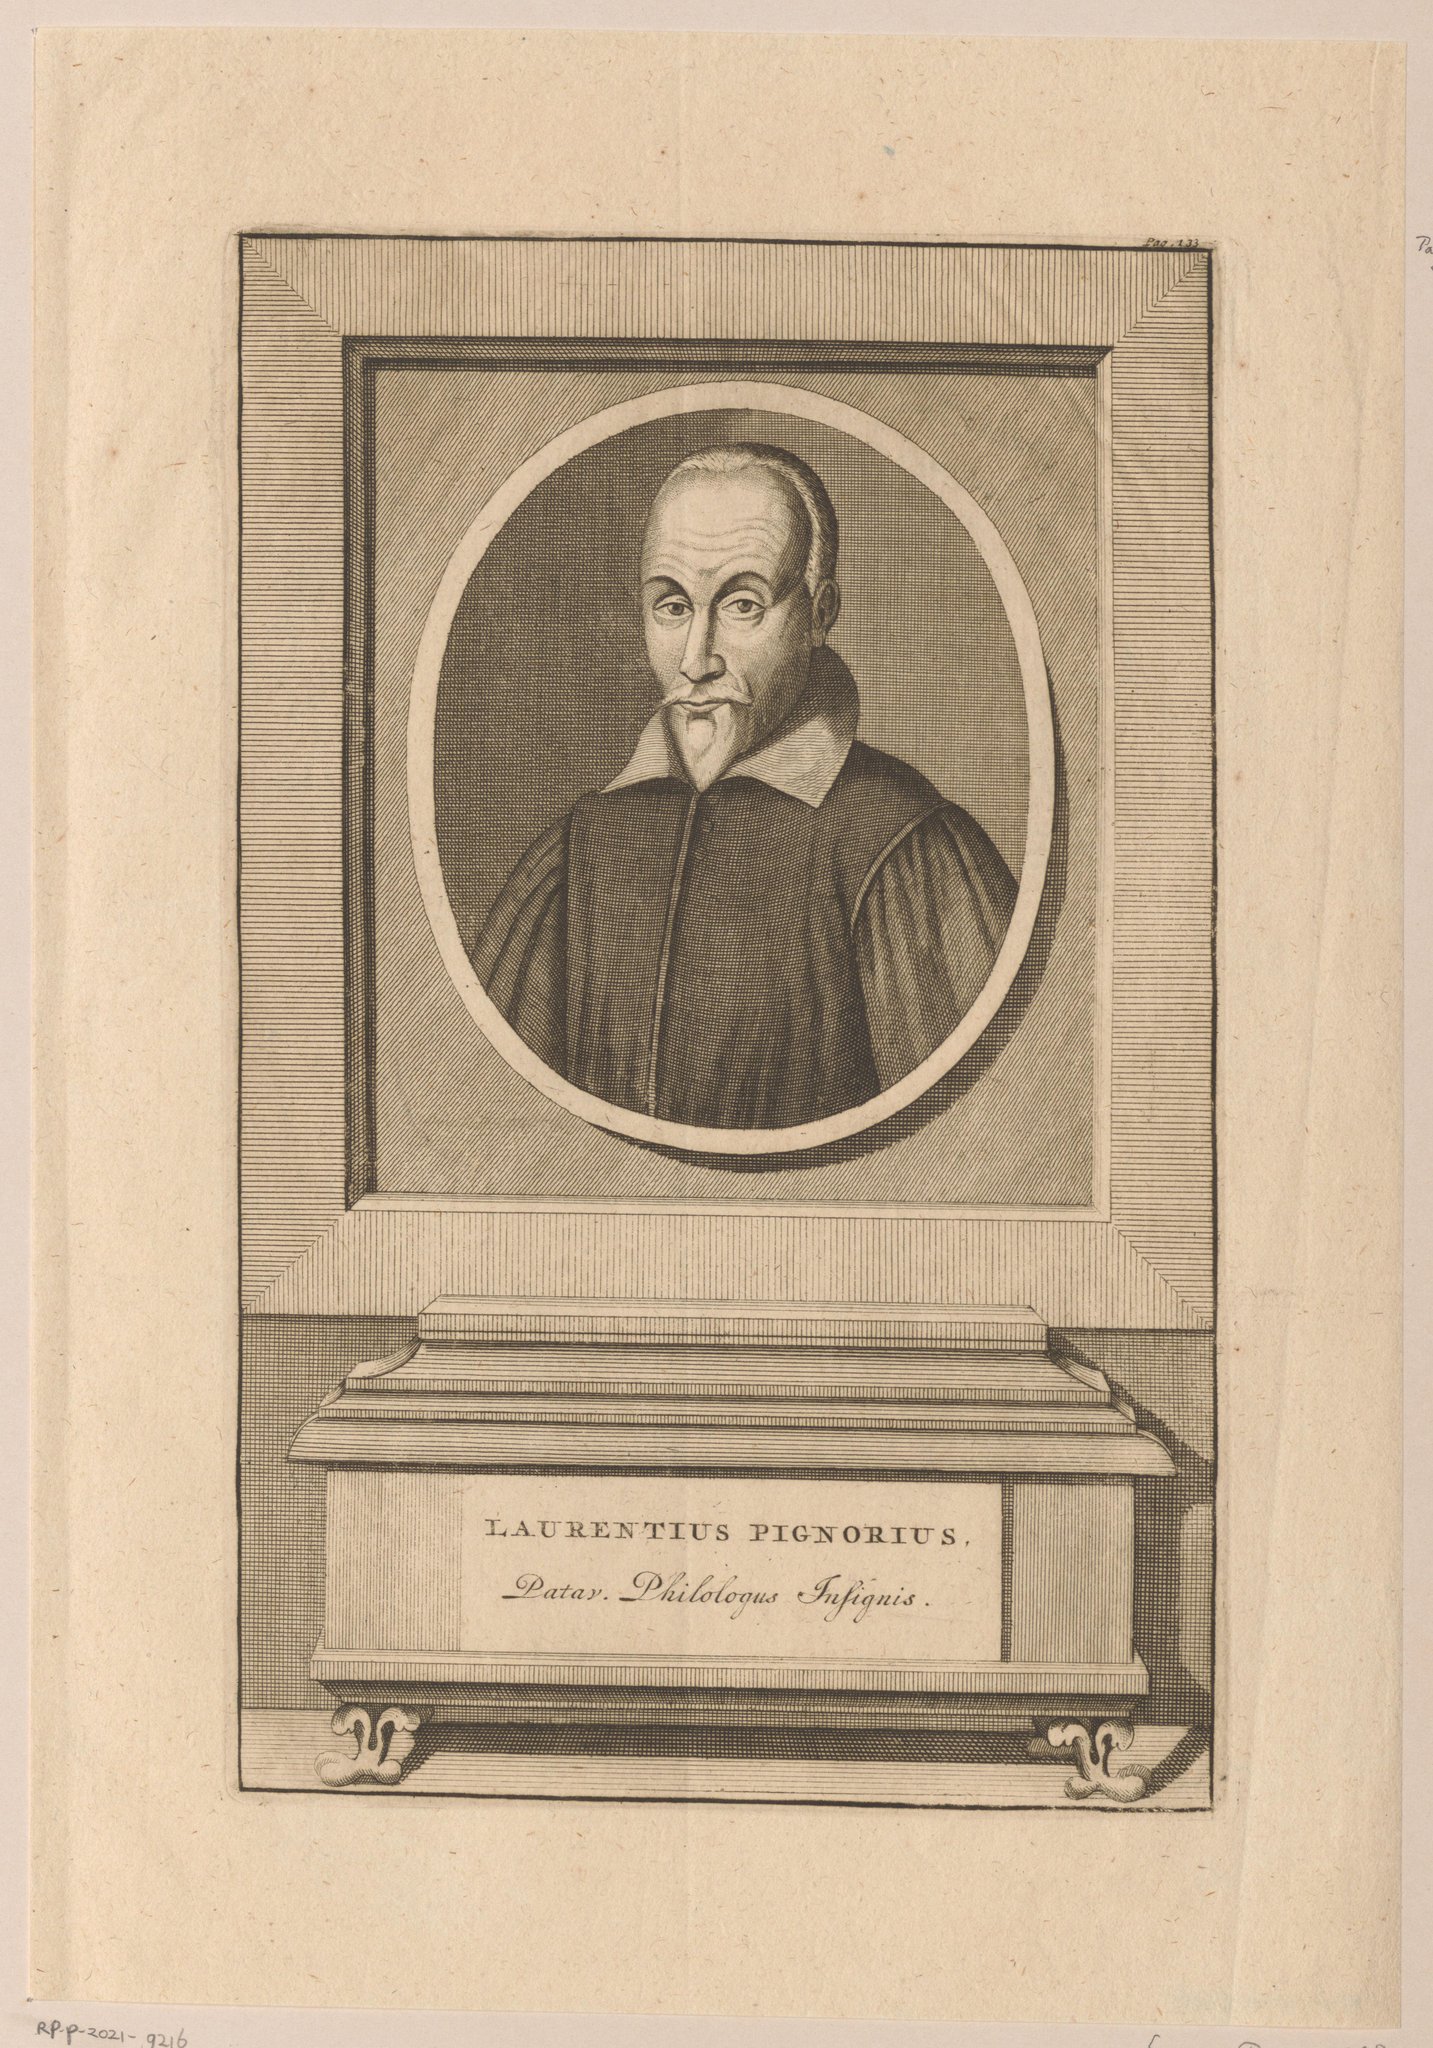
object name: book illustration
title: Portret van Lorenzo Pignoria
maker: Anonymous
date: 1722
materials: paper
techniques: engraving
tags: adult man, historical persons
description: Prent waarschijnlijk uit: Thesaurus antiquitatum et historiarum Italiae. Leiden: Pieter van der Aa, 1722. Andere staat gebruikt in de serie 'Imagines XLI. virorum celebriorum in politicis, historicis &c', uitgegeven bij Van der Aa, ca. 1720.